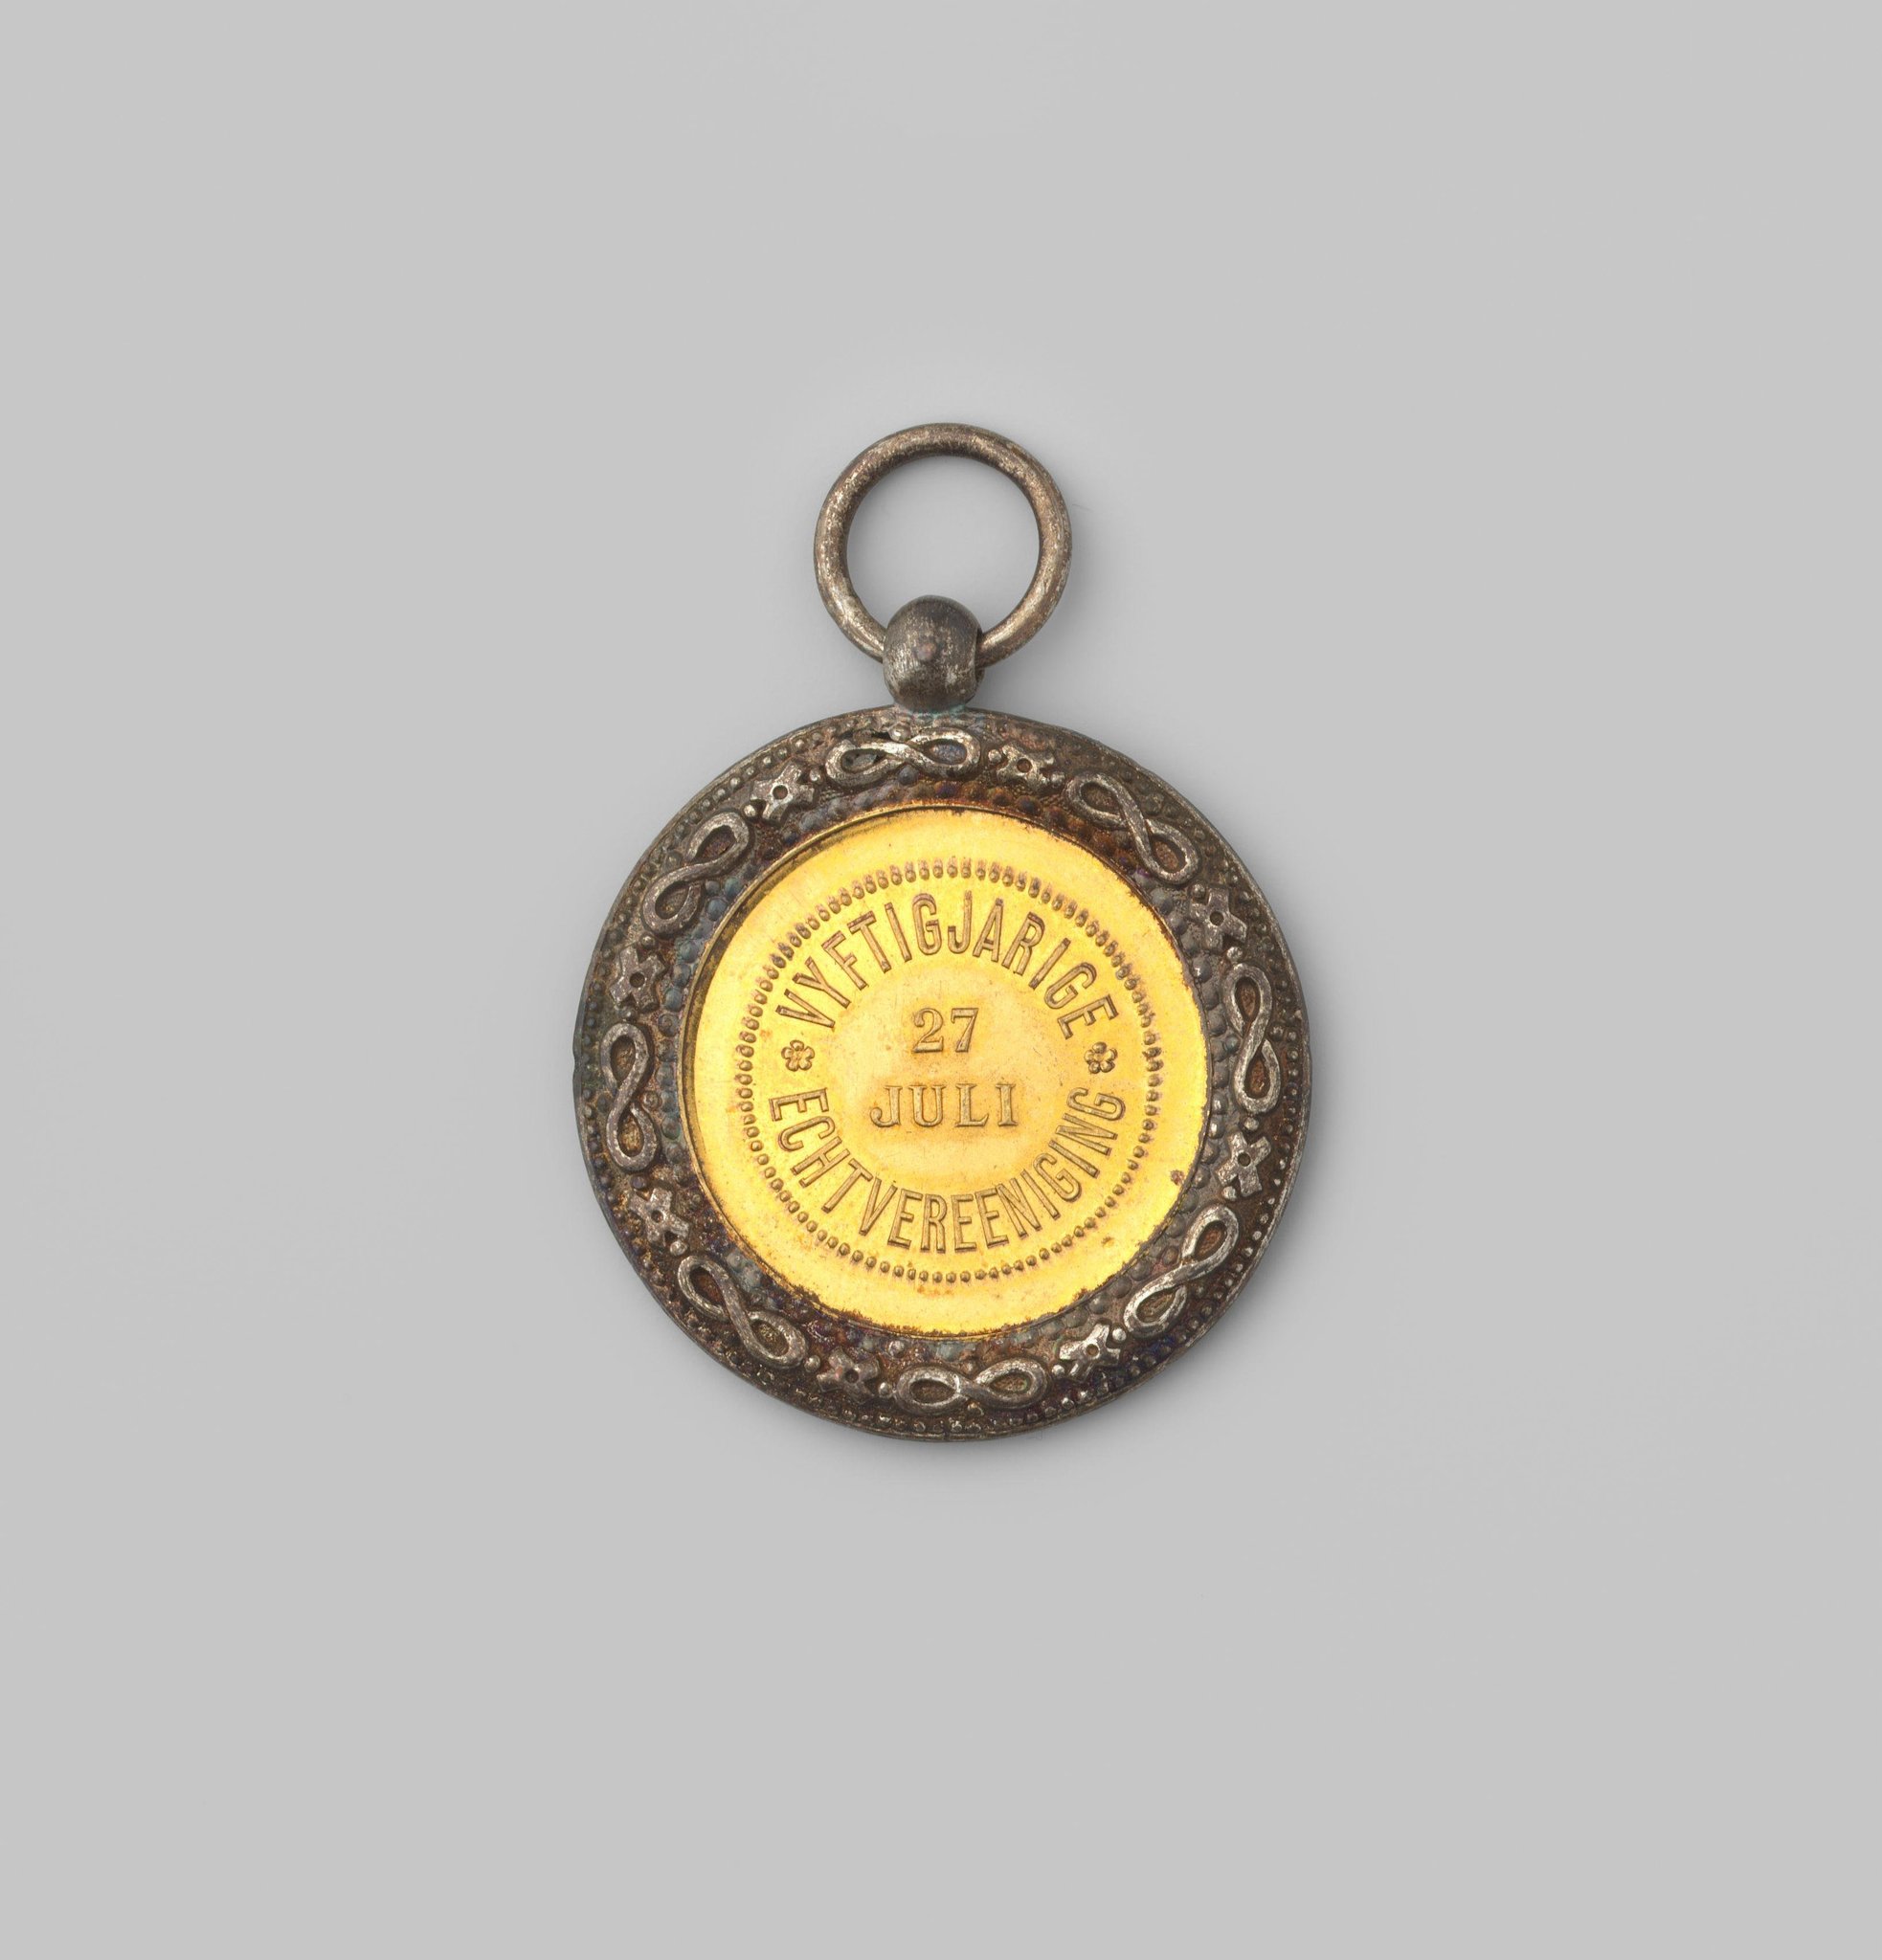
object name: pendant jewelry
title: Medaille ter herinnering aan de vijftigjarige echtvereniging van L. Jonker en M.E. van Zyp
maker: Anonymous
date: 1878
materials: gold, metal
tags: medal (considered as a piece of sculpture, regardless of its specific function), marriage, married couple, 'matrimonium'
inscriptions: inscription: ‘VIJFTIGJARIGE/ 27/ JULI/ ECHTVEREENIGING’, inscription: ‘L. JONKER/ M.E. VAN ZYP/ 1828-1878’